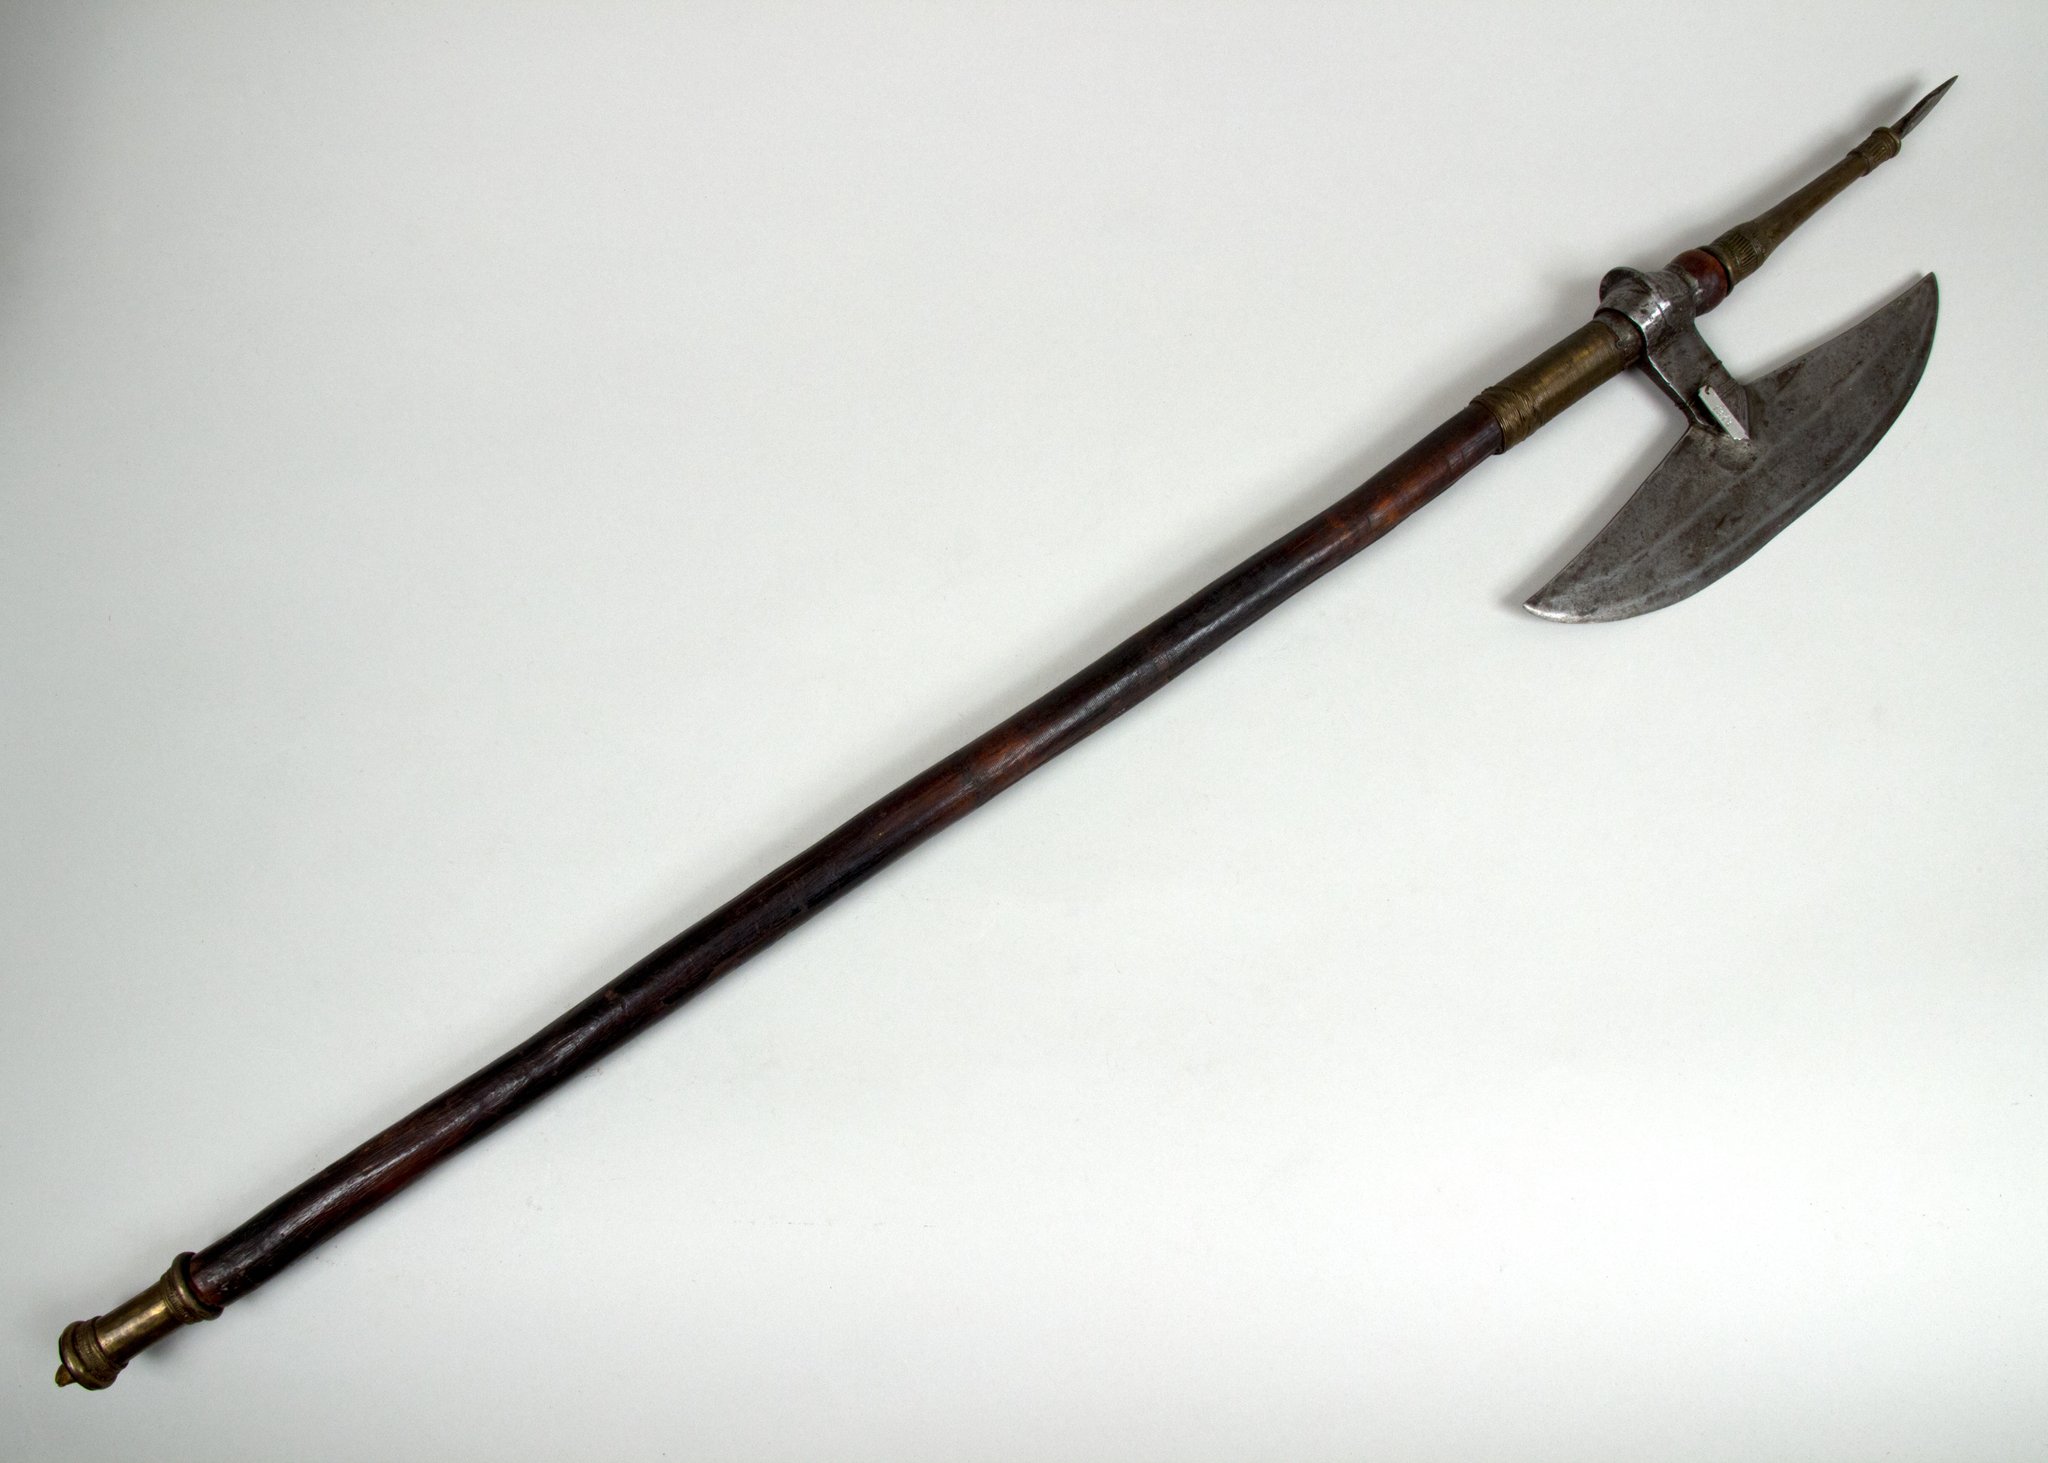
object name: axe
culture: indian, chota nagpur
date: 1701-1900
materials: brass, steel, wood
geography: india